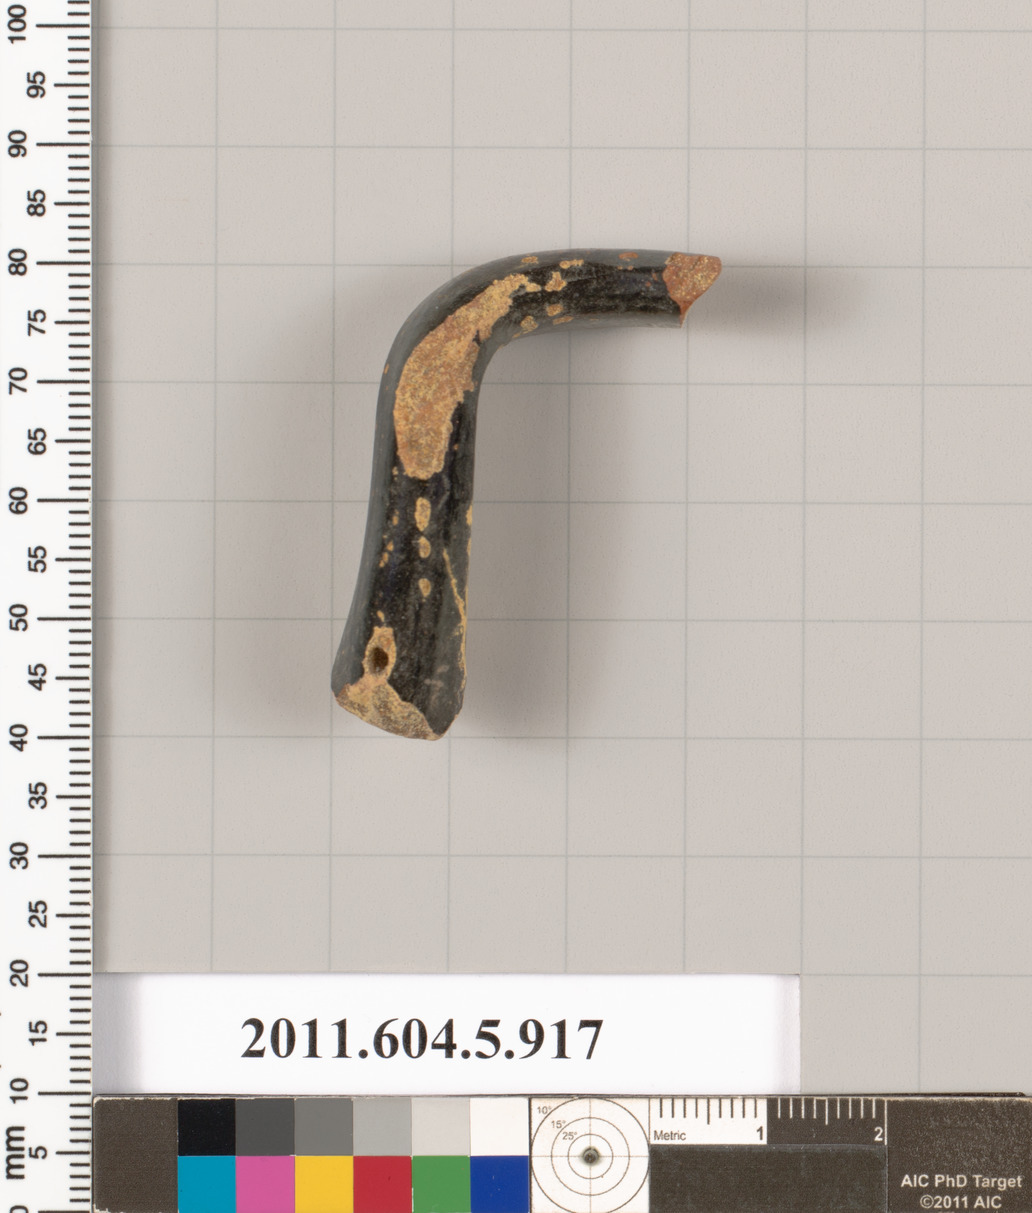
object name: kylix fragment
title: Terracotta fragment of a kylix (drinking cup)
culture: greek, attic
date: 500-301 BCE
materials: terracotta